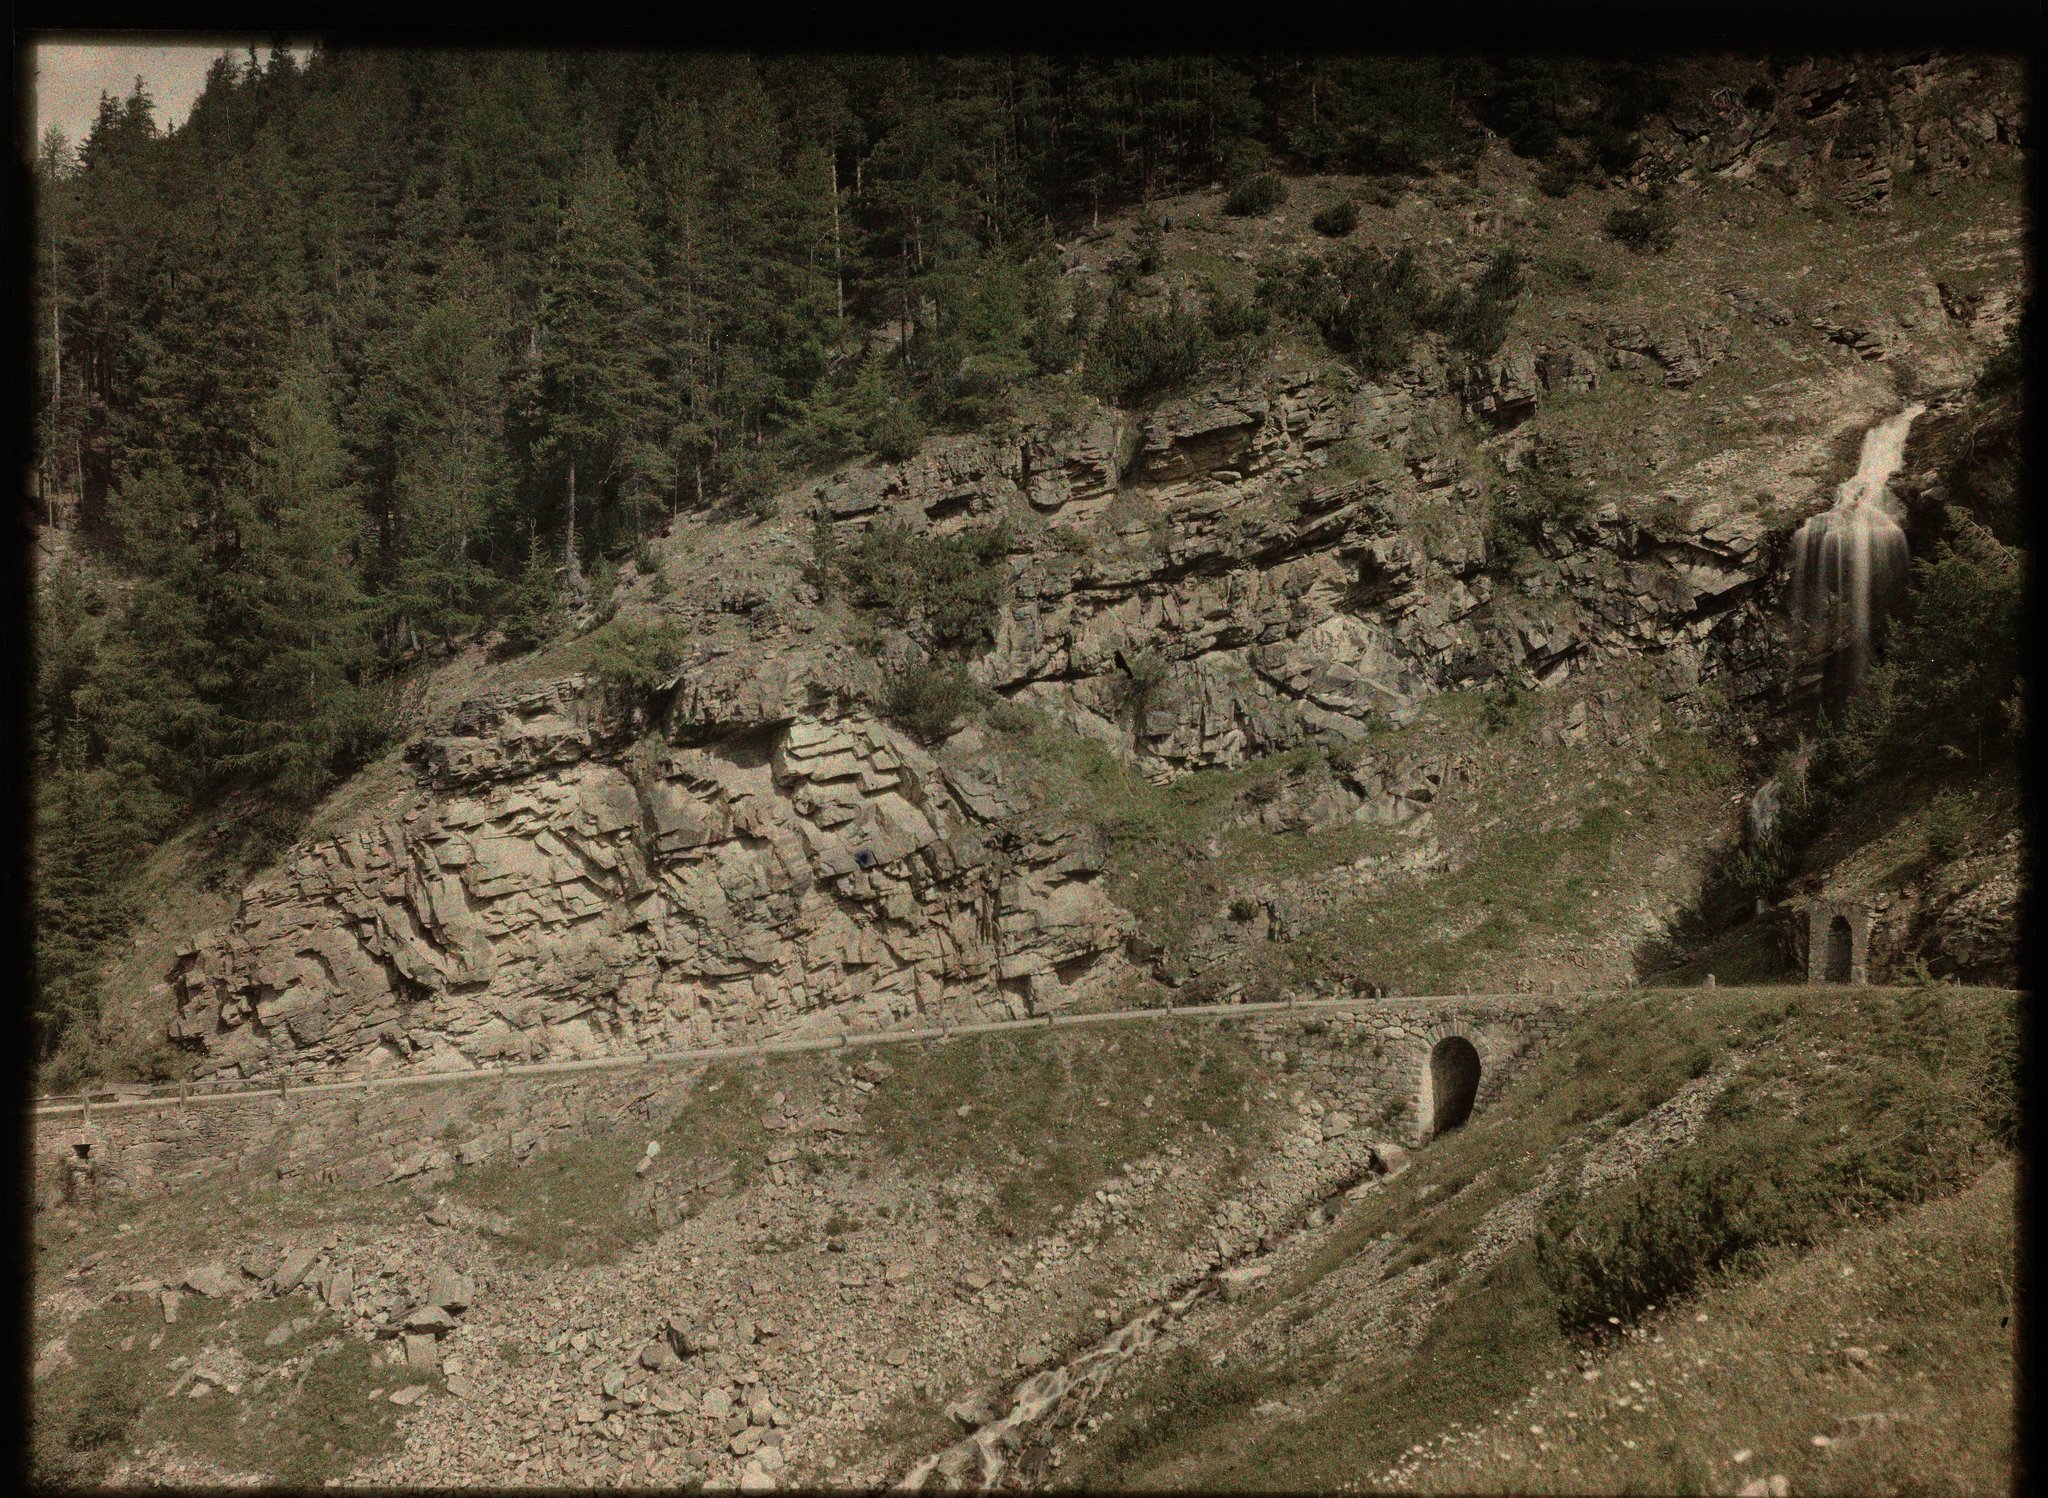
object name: photograph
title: Gezicht op een bergwand, doorsneden door een weg, met rechts een kapel (?)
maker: adolphe burdet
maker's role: fotograaf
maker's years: 1860-1940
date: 1907-1930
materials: glass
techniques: autochrome process, slide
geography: netherlands